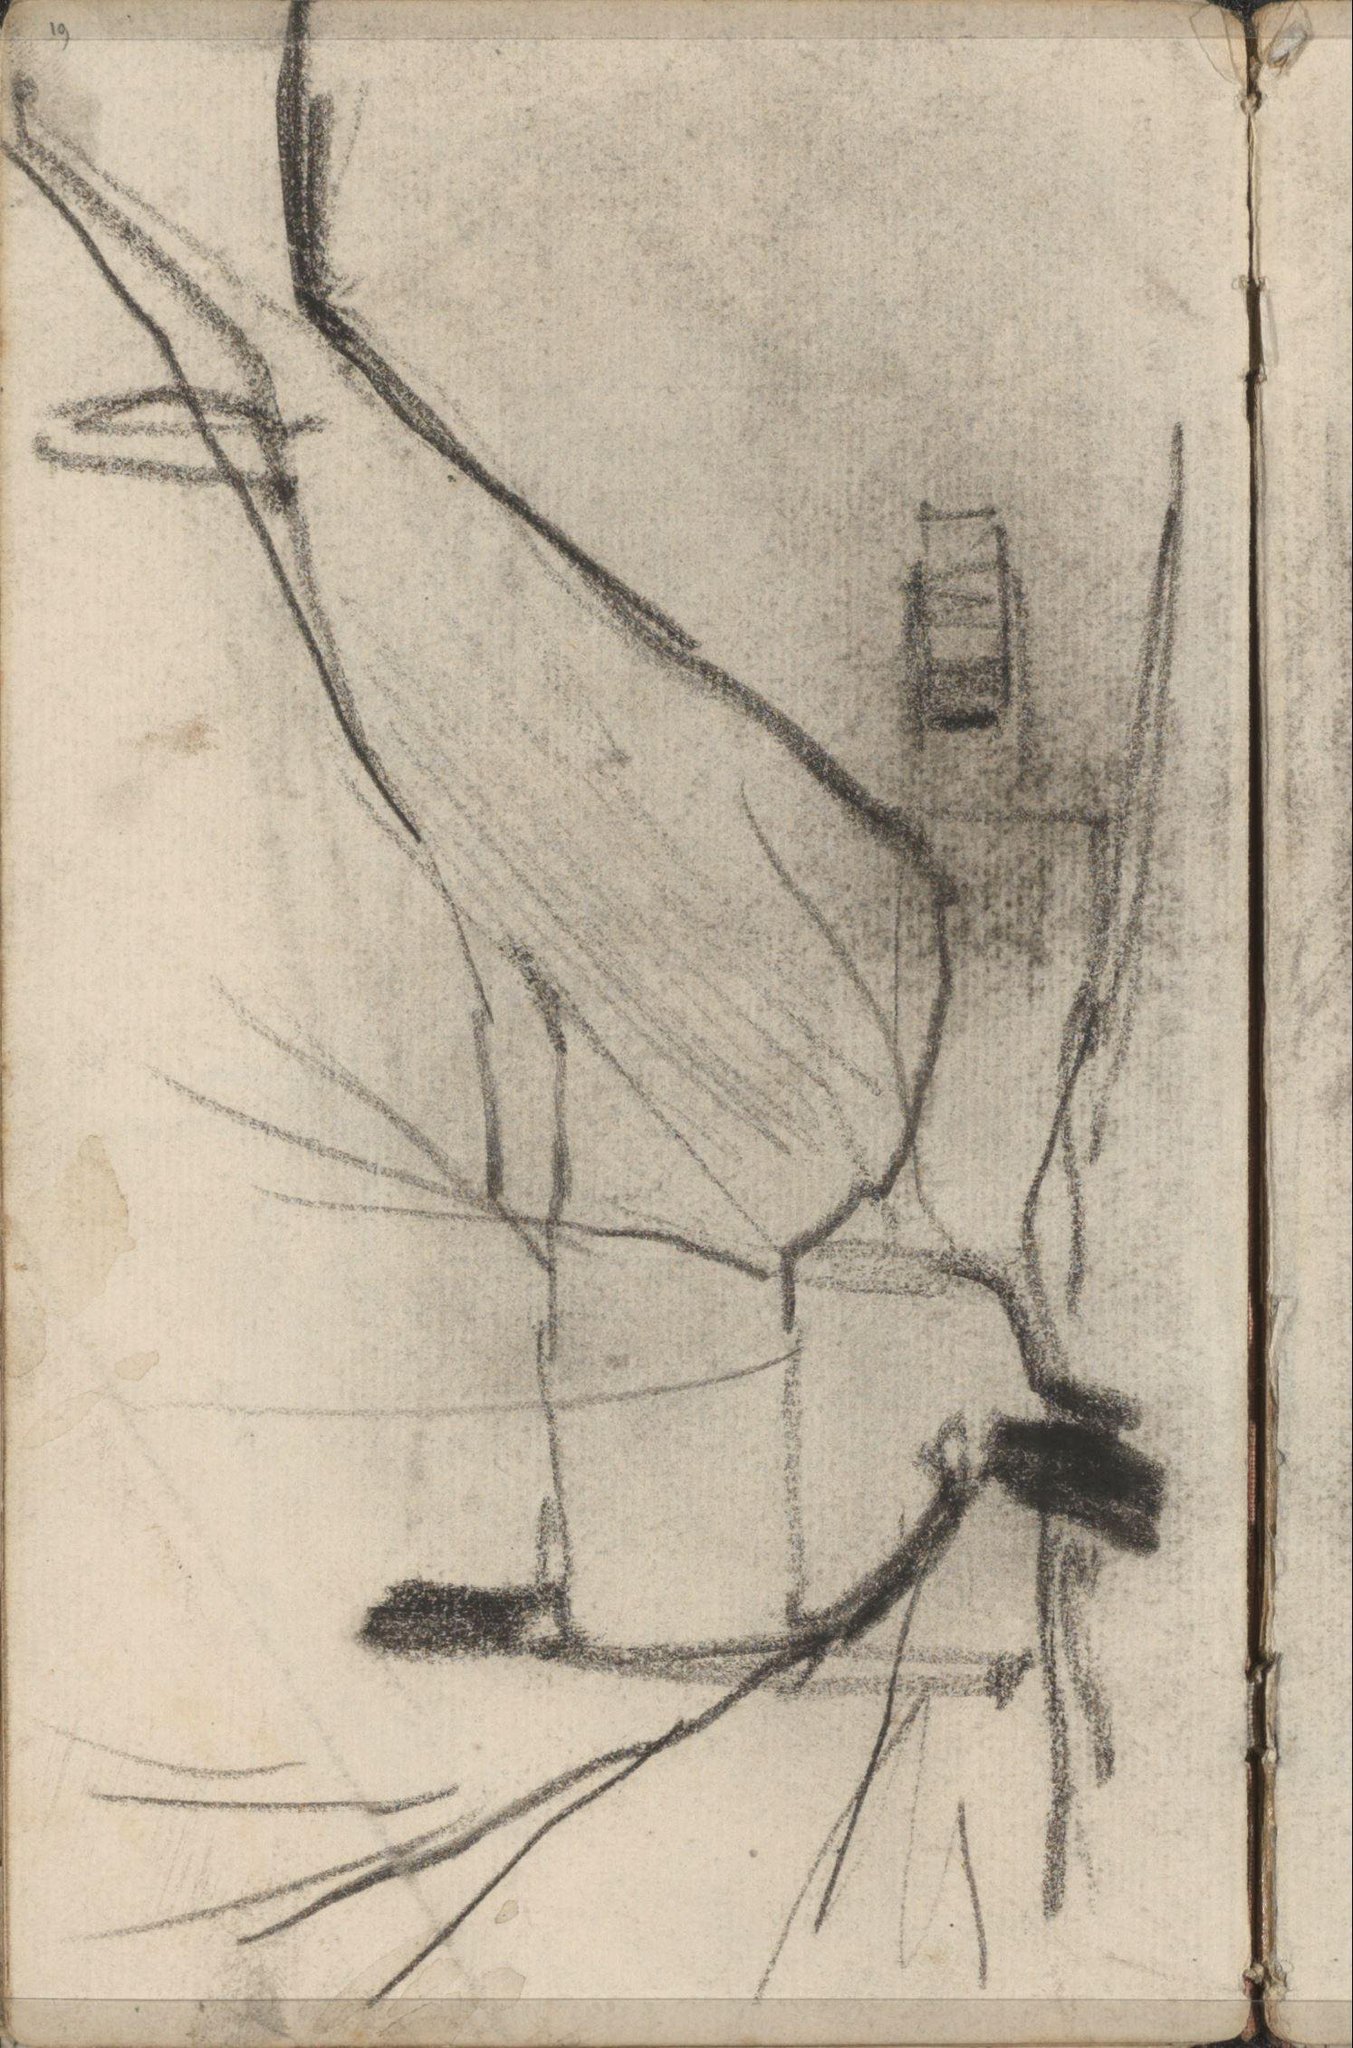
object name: sketchbook leaf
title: Boerderij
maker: george hendrik breitner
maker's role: draughtsman, painter, print maker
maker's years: 1857-1923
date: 1884-1886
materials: chalk, paper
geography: the hague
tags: farm (building)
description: Pagina 19 uit een schetsboek met 29 bladen.